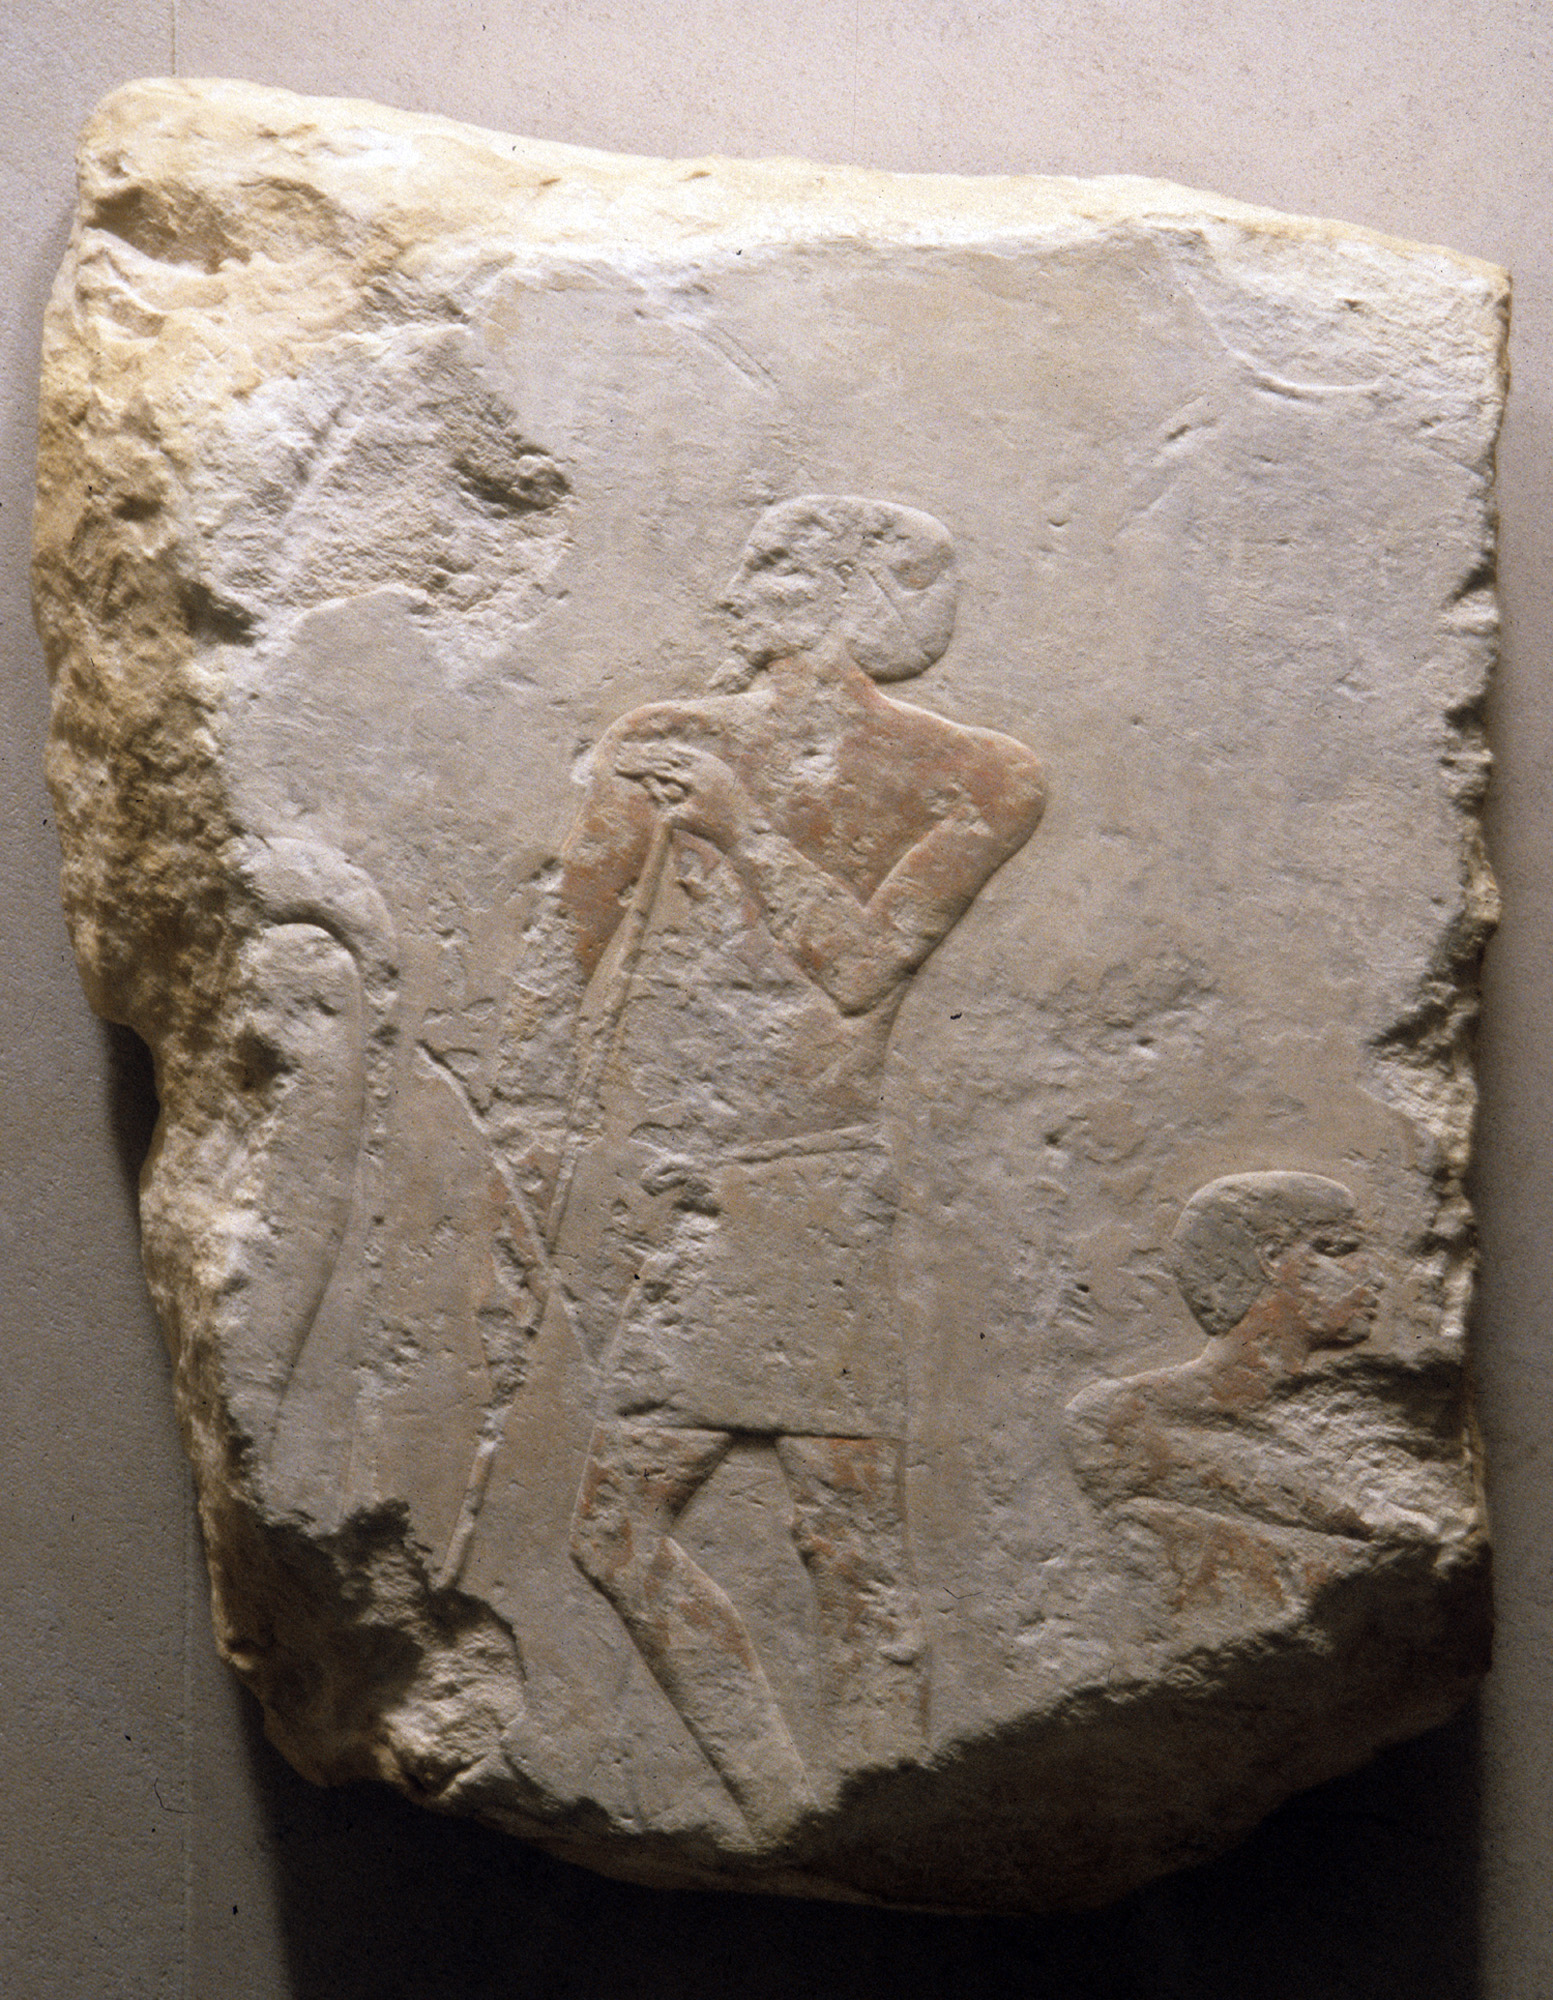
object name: relief, cattle farming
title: Relief depicting cattle farming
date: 2323-2150 BCE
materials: limestone, paint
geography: egypt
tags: men,farmers